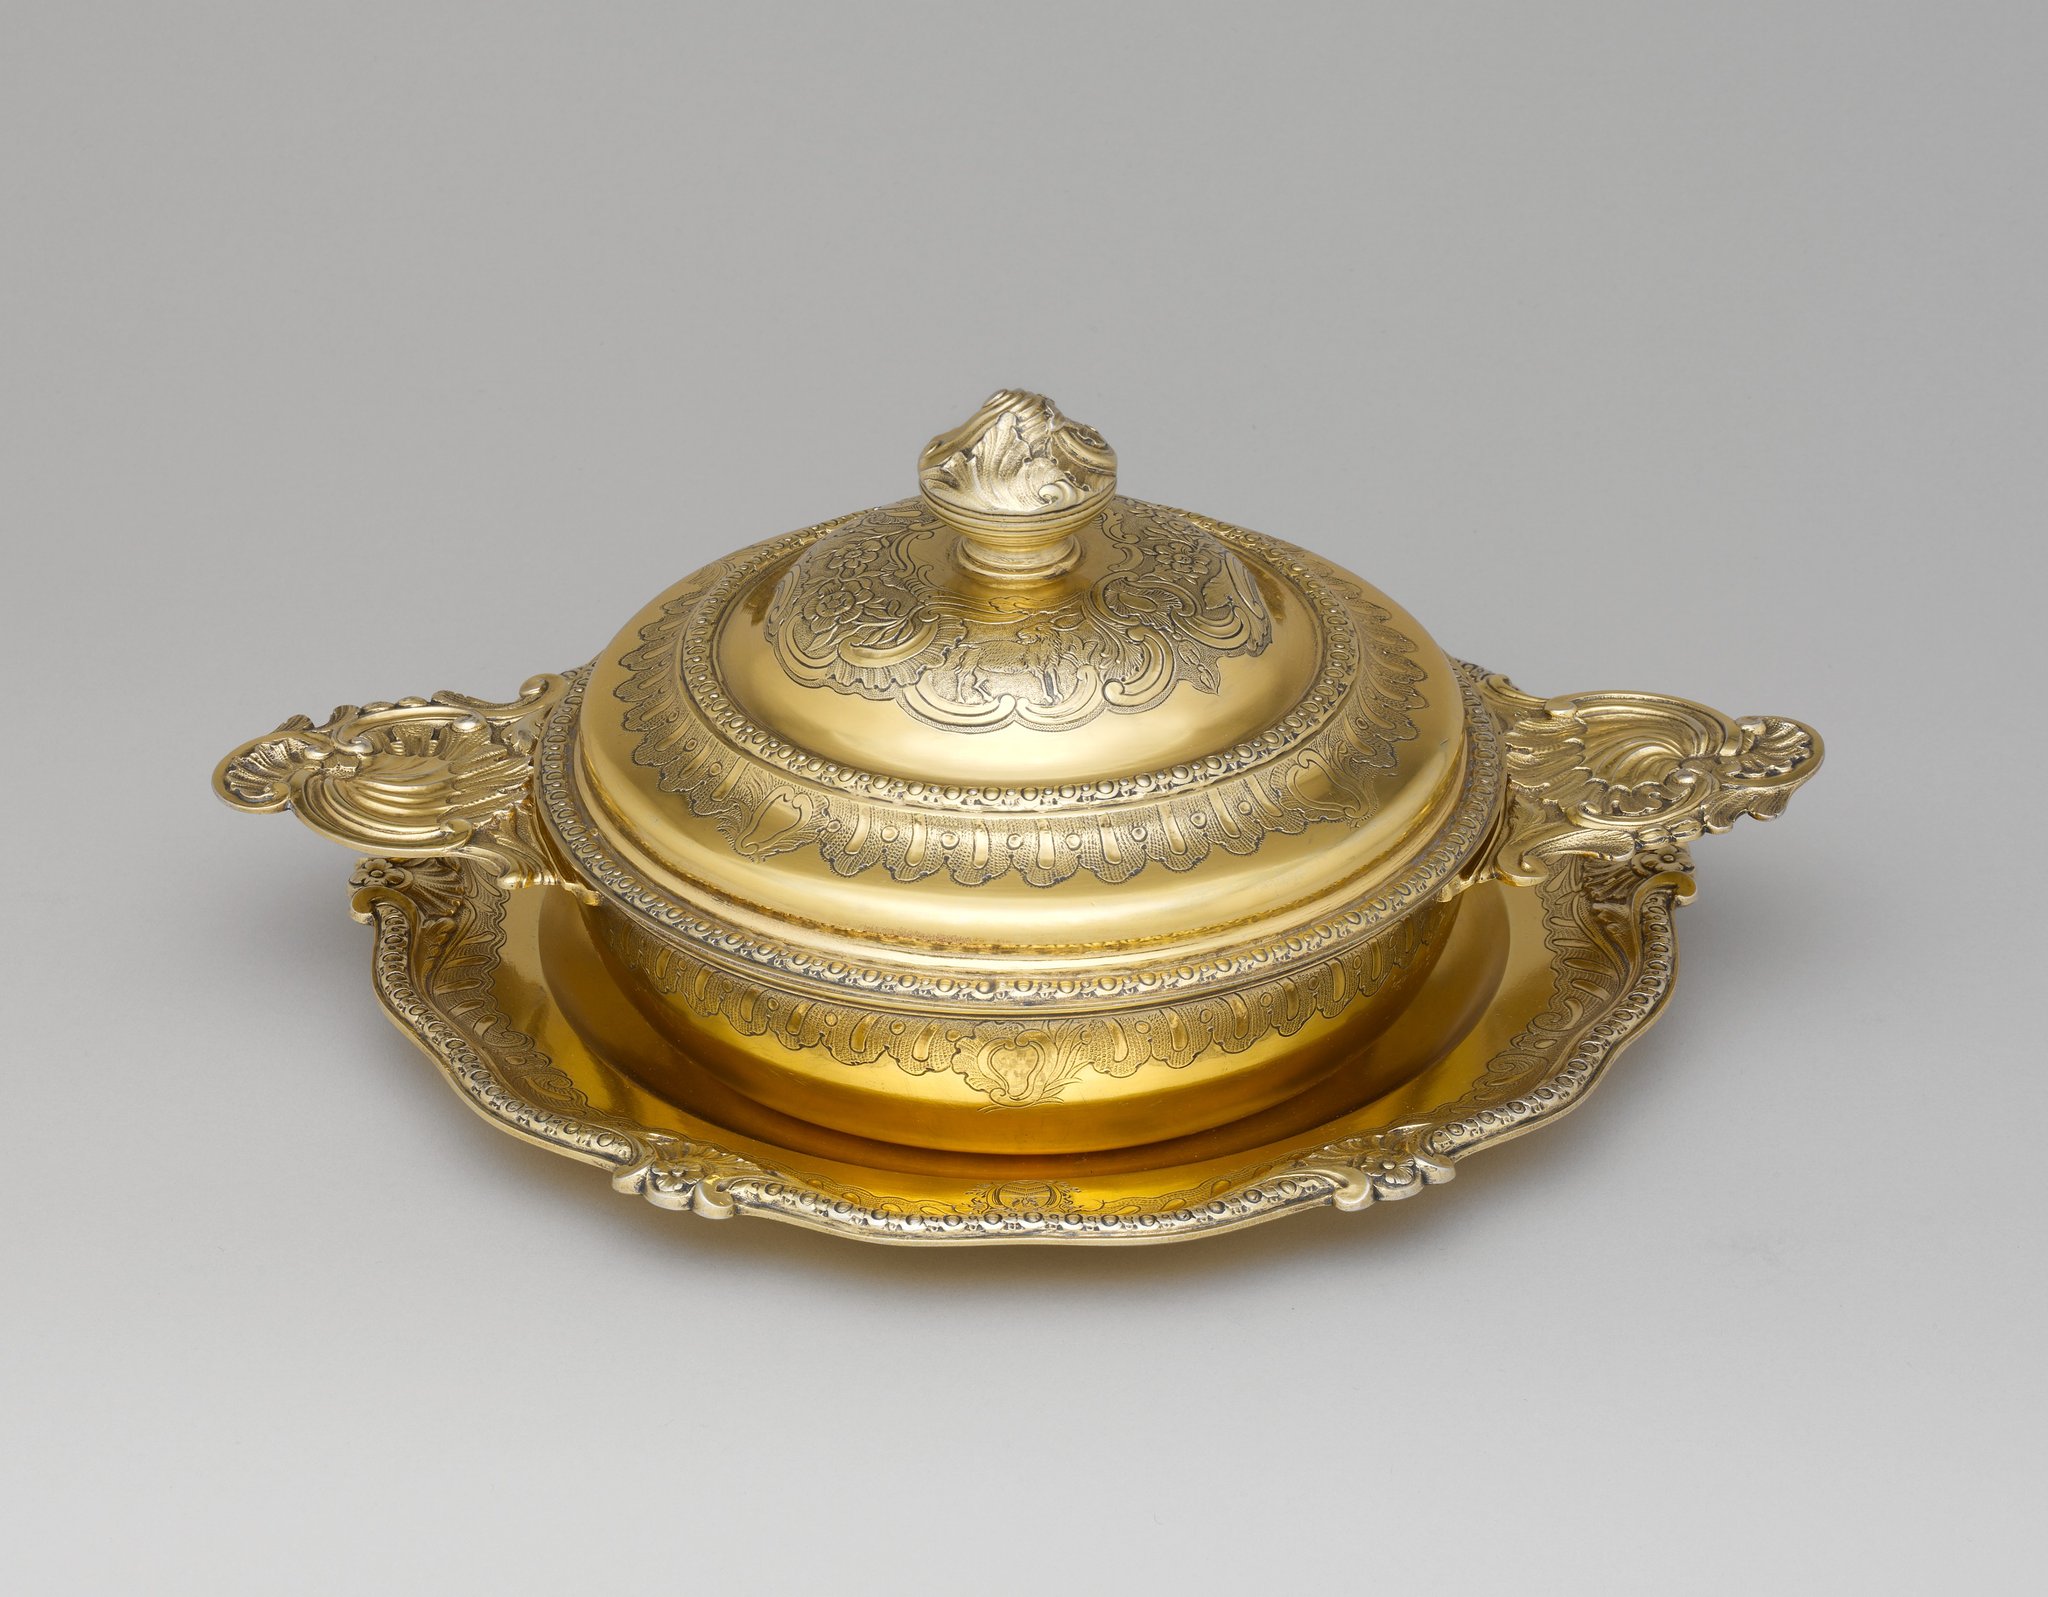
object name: bowl with cover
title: Bowl with cover (Écuelle) (part of a traveling set)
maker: joachim-frédéric kirstein i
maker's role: maker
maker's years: 1729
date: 1756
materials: silver gilt